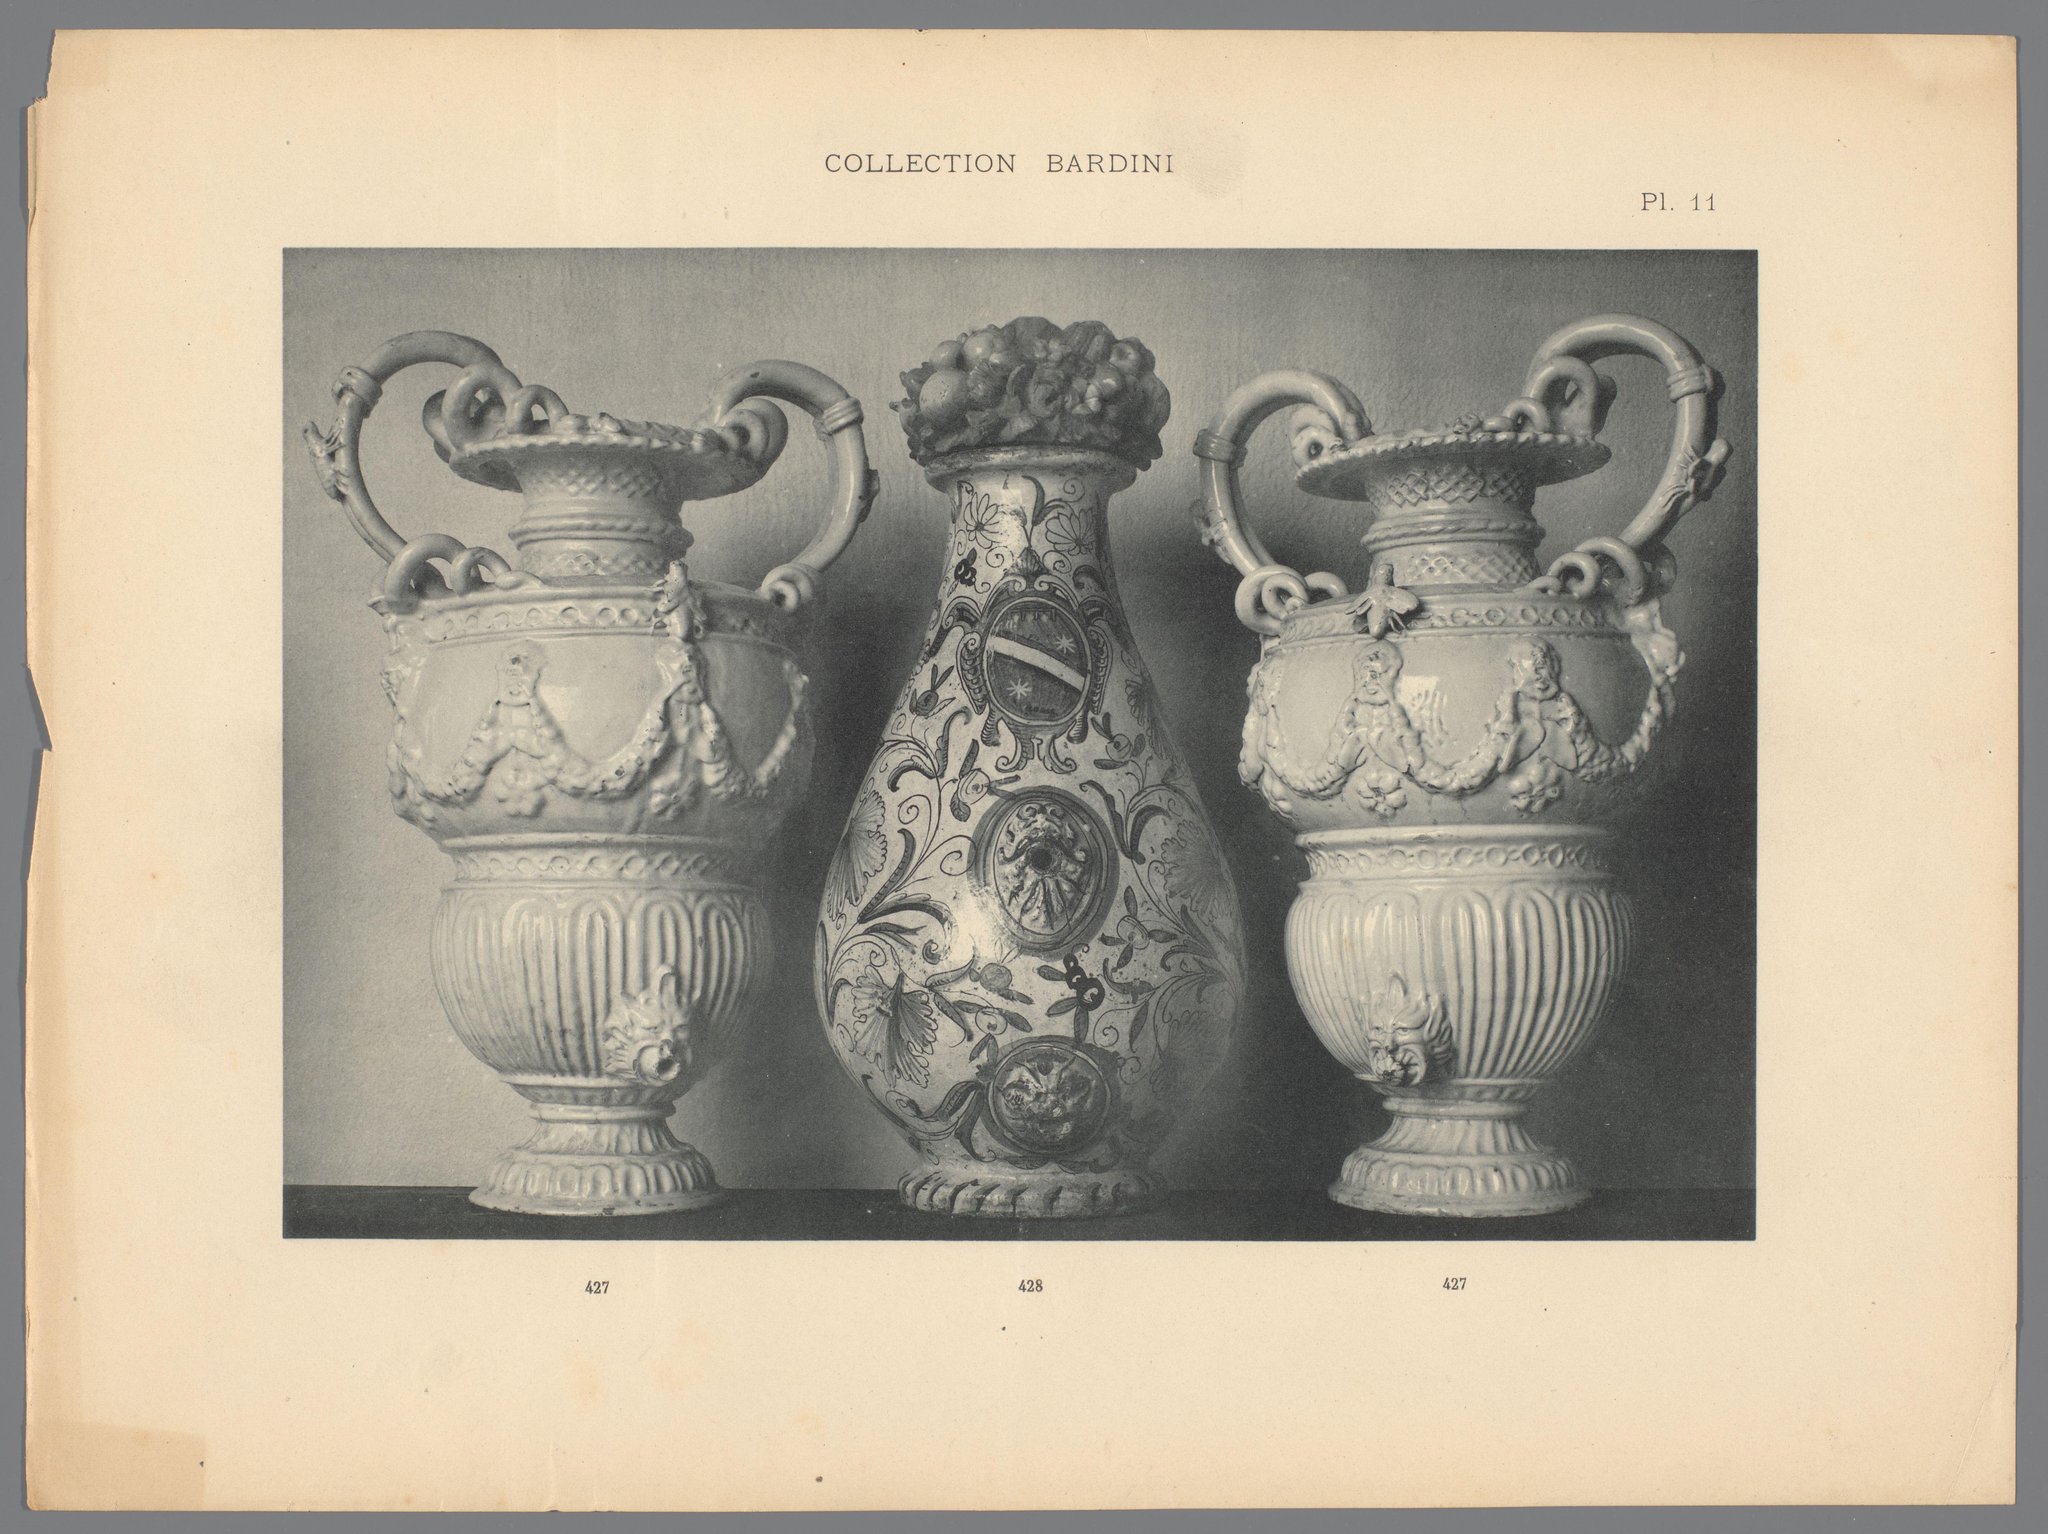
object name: photomechanical print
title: Collection Bardini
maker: Anonymous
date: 1875-1930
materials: paper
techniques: photograph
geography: florence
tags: containers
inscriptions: number: ‘Pl. 11’